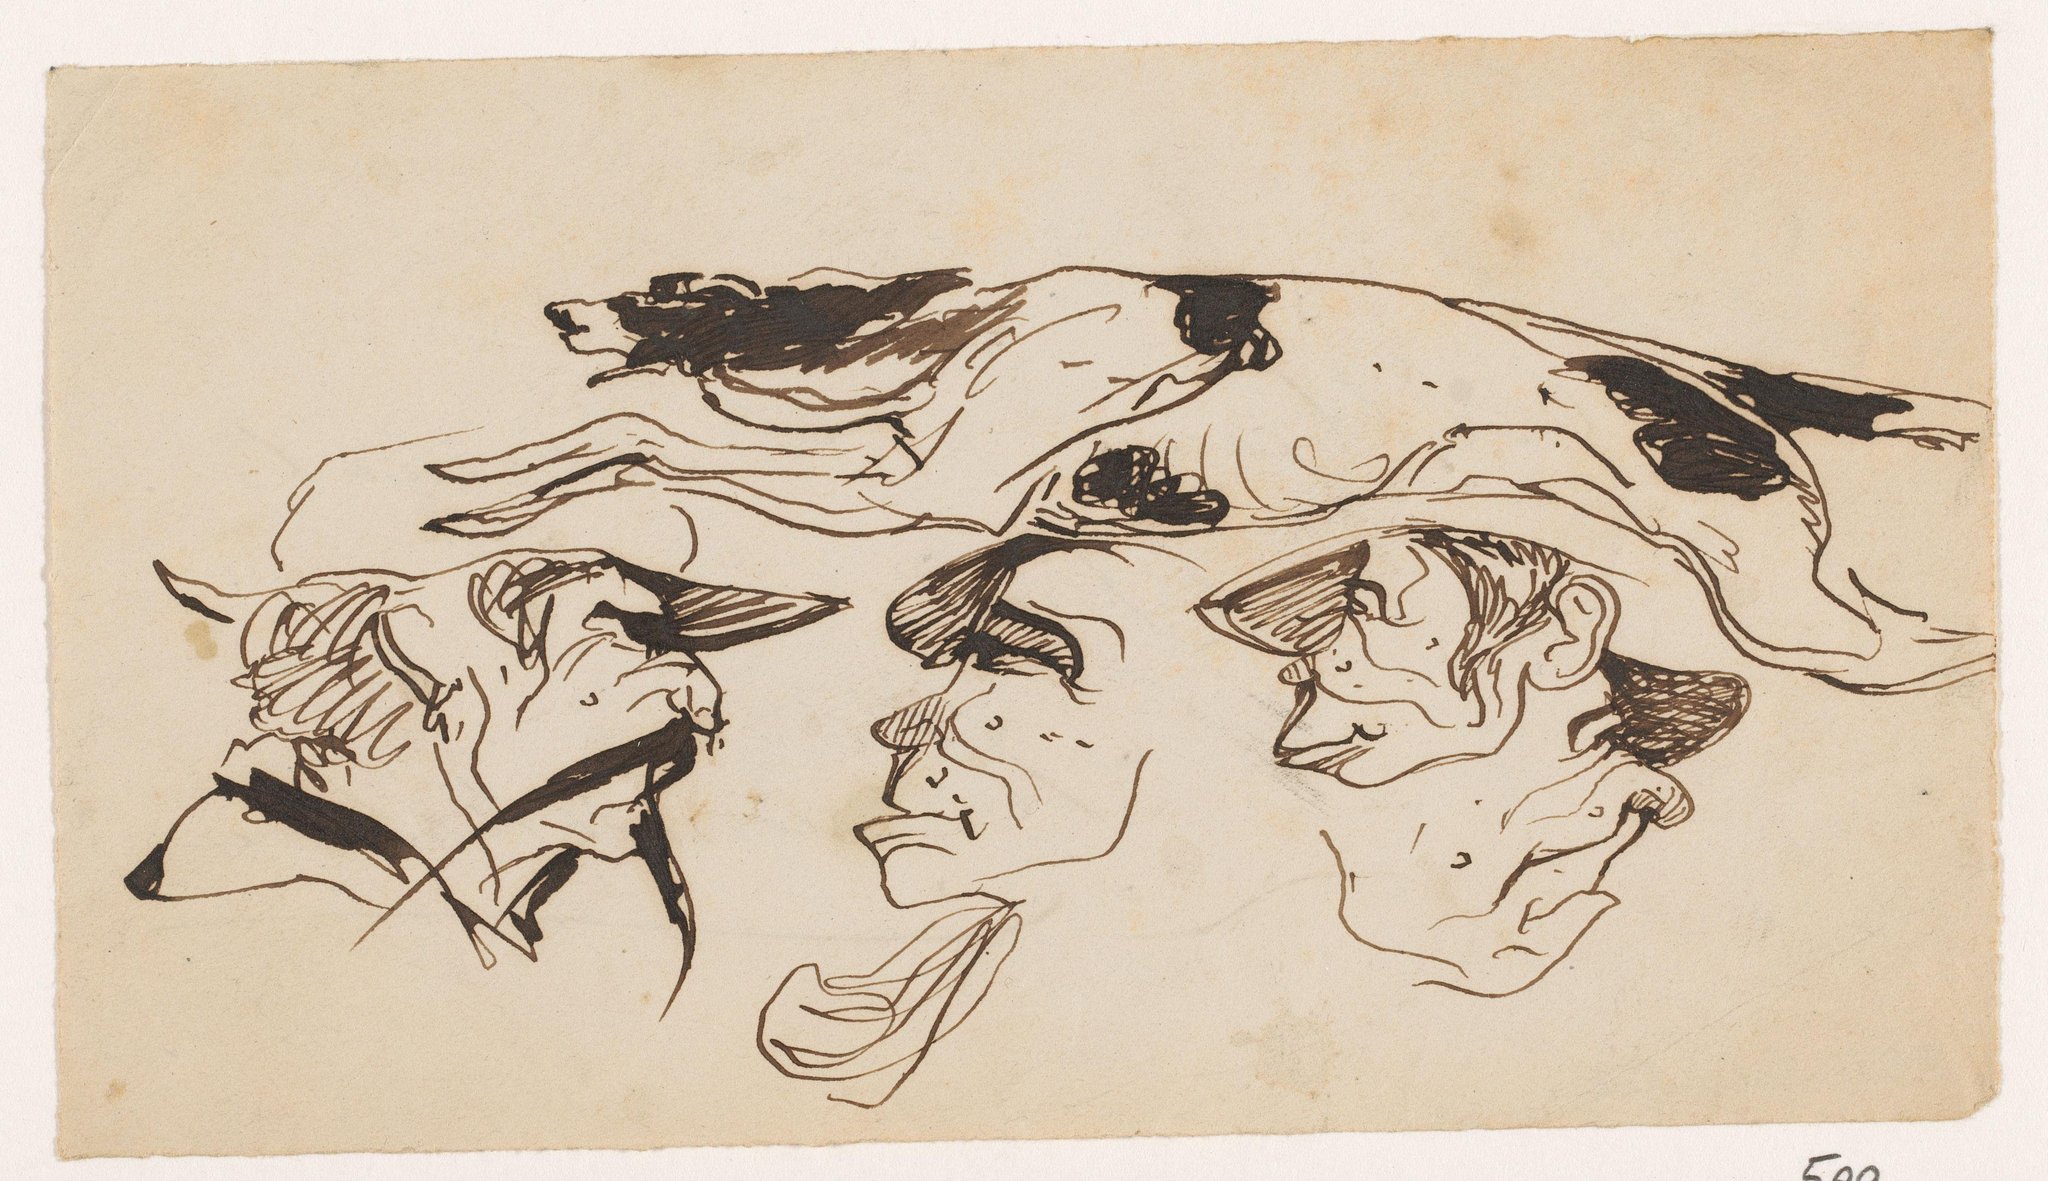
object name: drawing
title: Koppen en een hond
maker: johannes tavenraat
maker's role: draughtsman, painter, print maker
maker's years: 1809-1881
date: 1840-1880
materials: ink, paper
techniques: pen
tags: caricatures (human types), dog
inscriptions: collector's mark: Lugt 2228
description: Koppen en een hond. Getekend op de achterzijde van een envelop gericht aan J. Tavenraat.